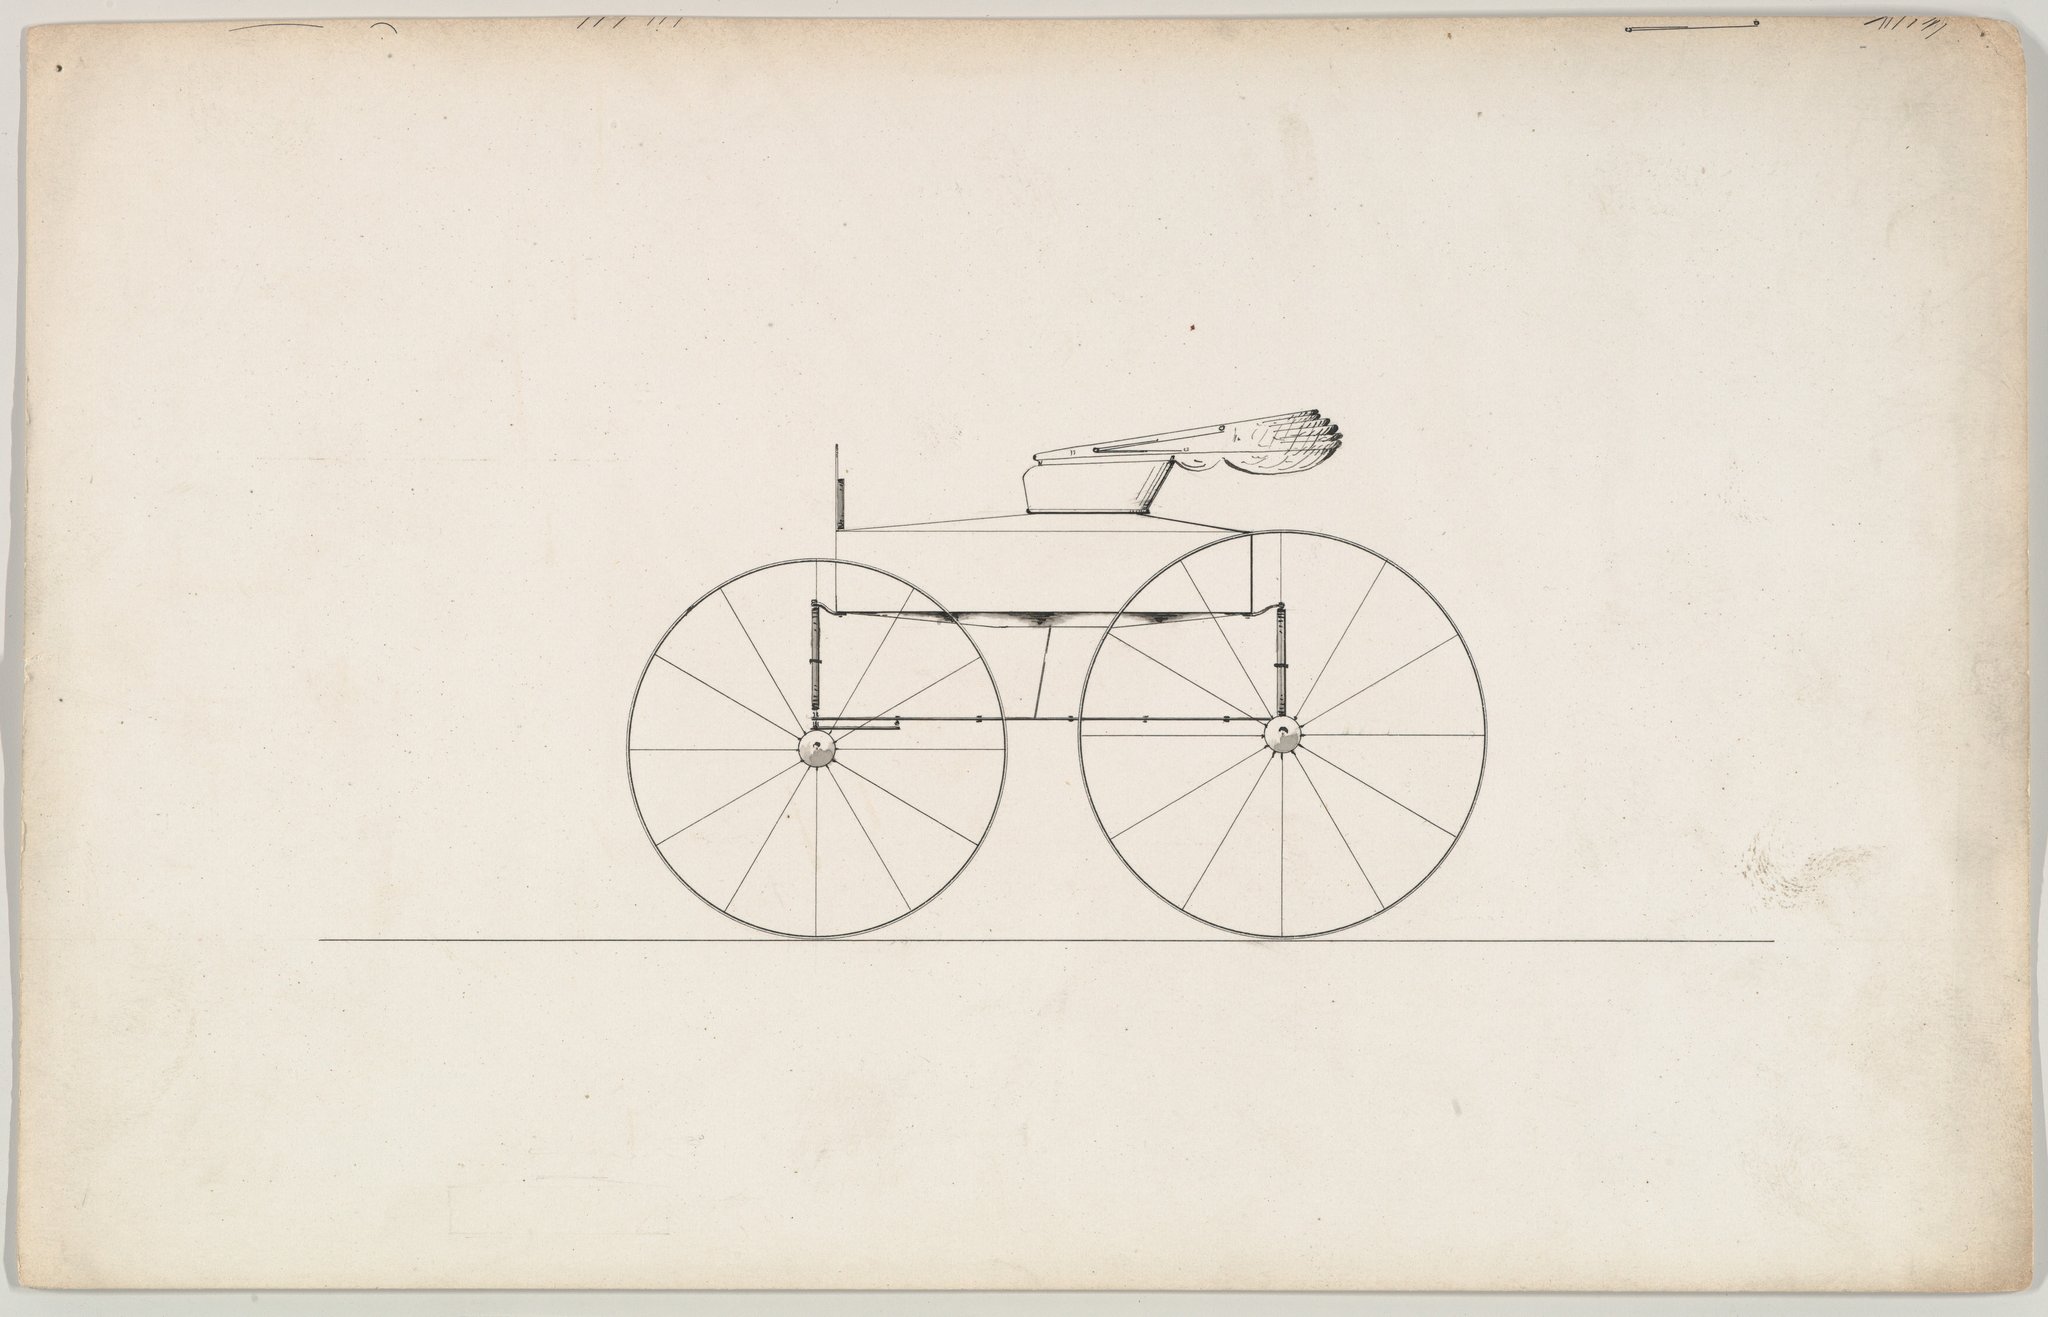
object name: drawing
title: Design for Road Wagon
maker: brewster & co.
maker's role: manufacturer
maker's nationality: american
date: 1850-1870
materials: ink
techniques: pen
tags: carriages